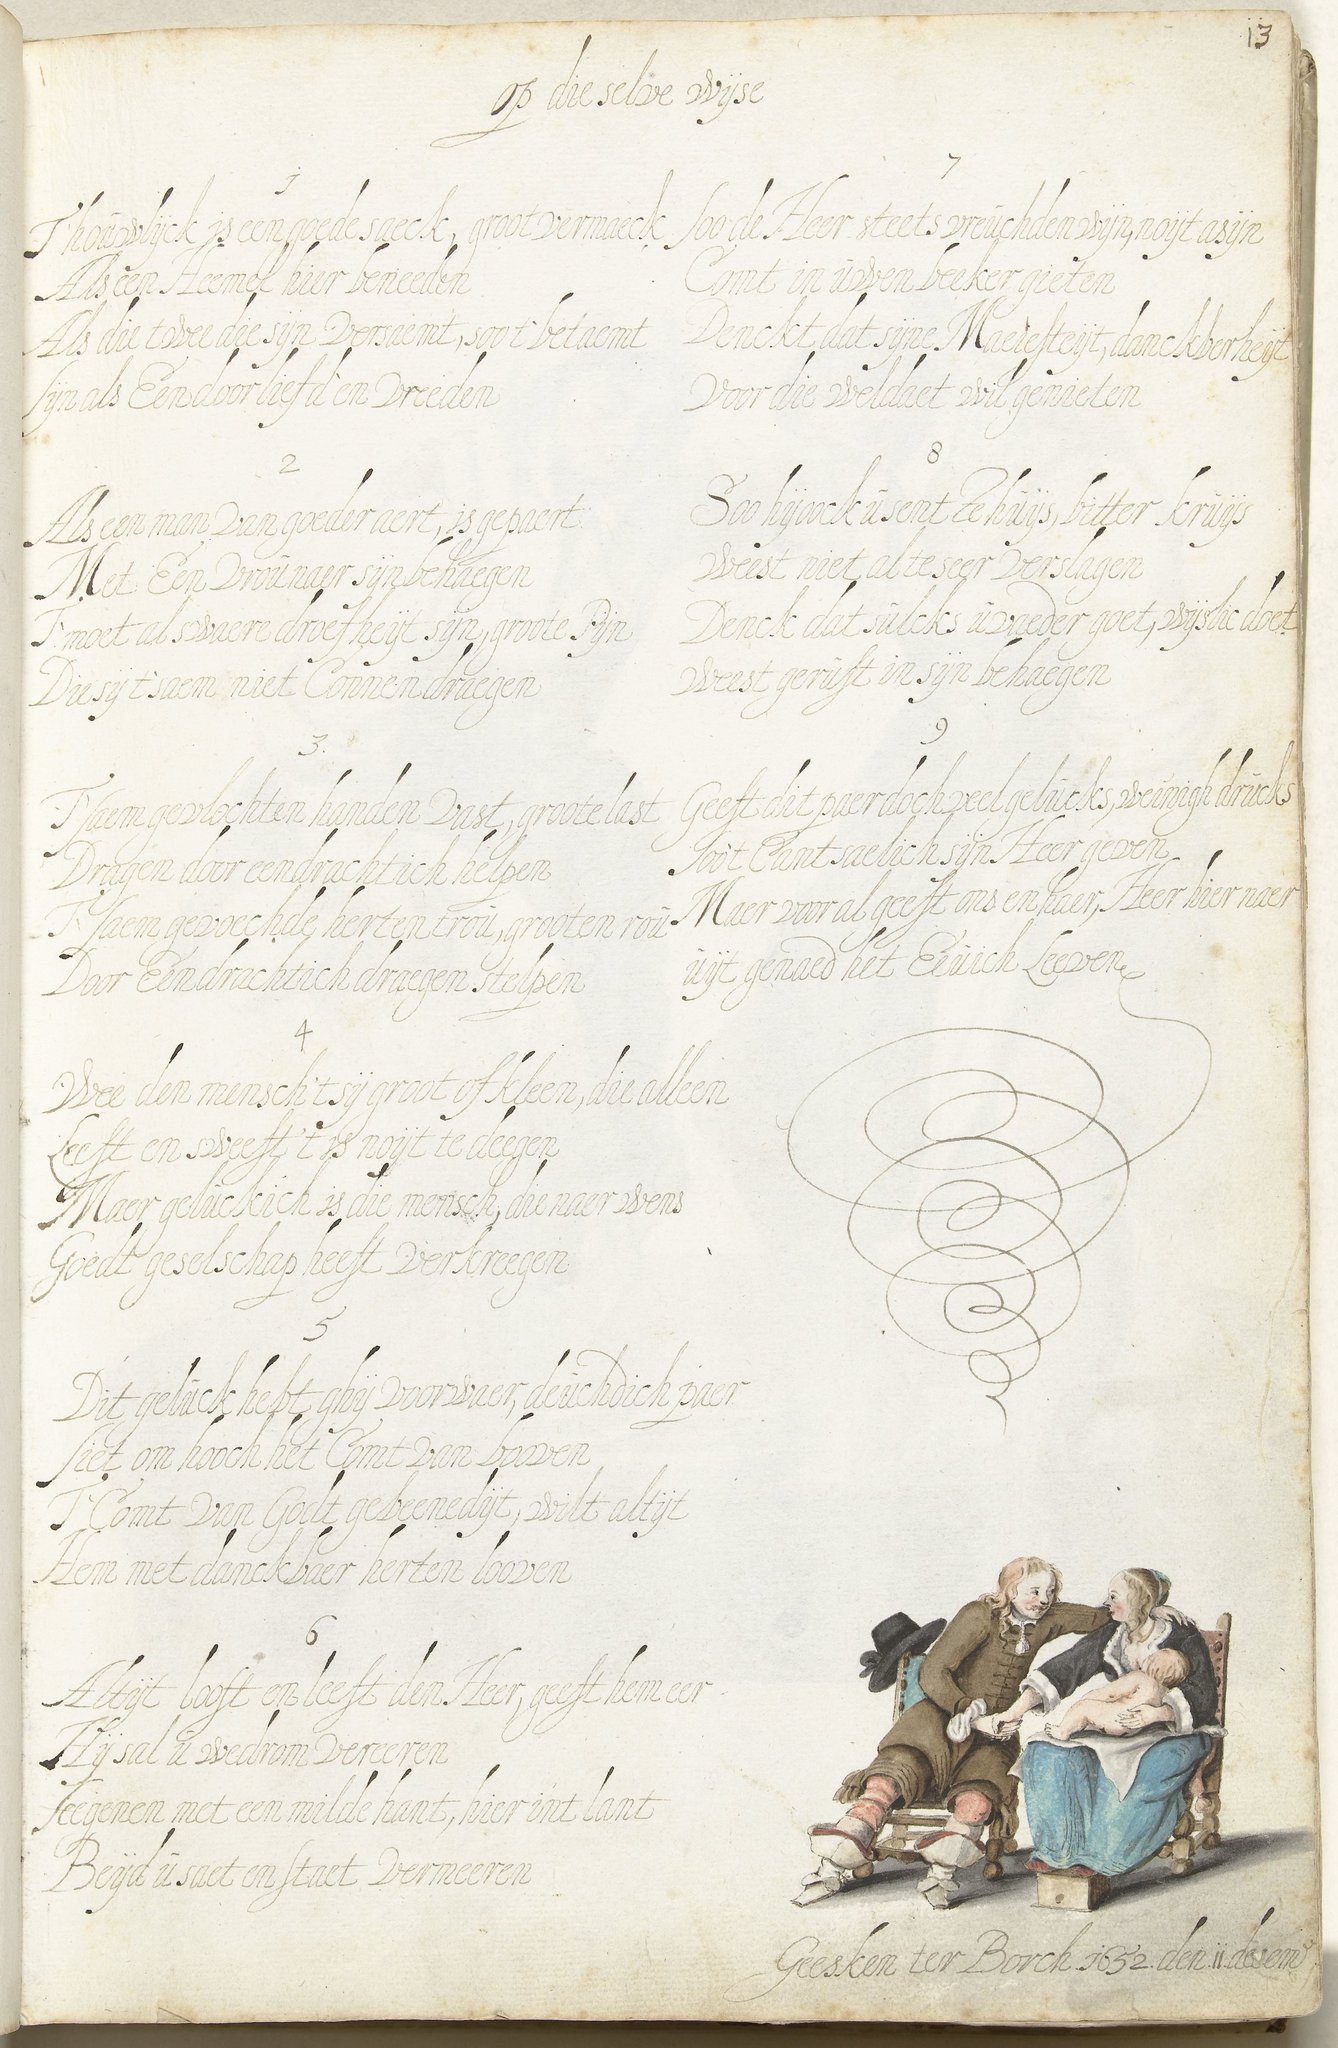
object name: calligraphy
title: Echtpaar met kindje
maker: gesina ter borch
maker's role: draughtsman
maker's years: 1633-1690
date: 1652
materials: ink, paper, watercolor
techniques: brush, calligraphy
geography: zwolle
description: Het gedicht is bedacht door B. Busschof, H. Zoeteboom bracht het lied uit (mogelijk een gelegenheidgedicht voor een speciaal paar) in: 't Kleyn lusthofje, vol van bruylofts-zangen, echt-liedekens, houwelijcx-baken en feest gedichten (maar met een andere melodie).